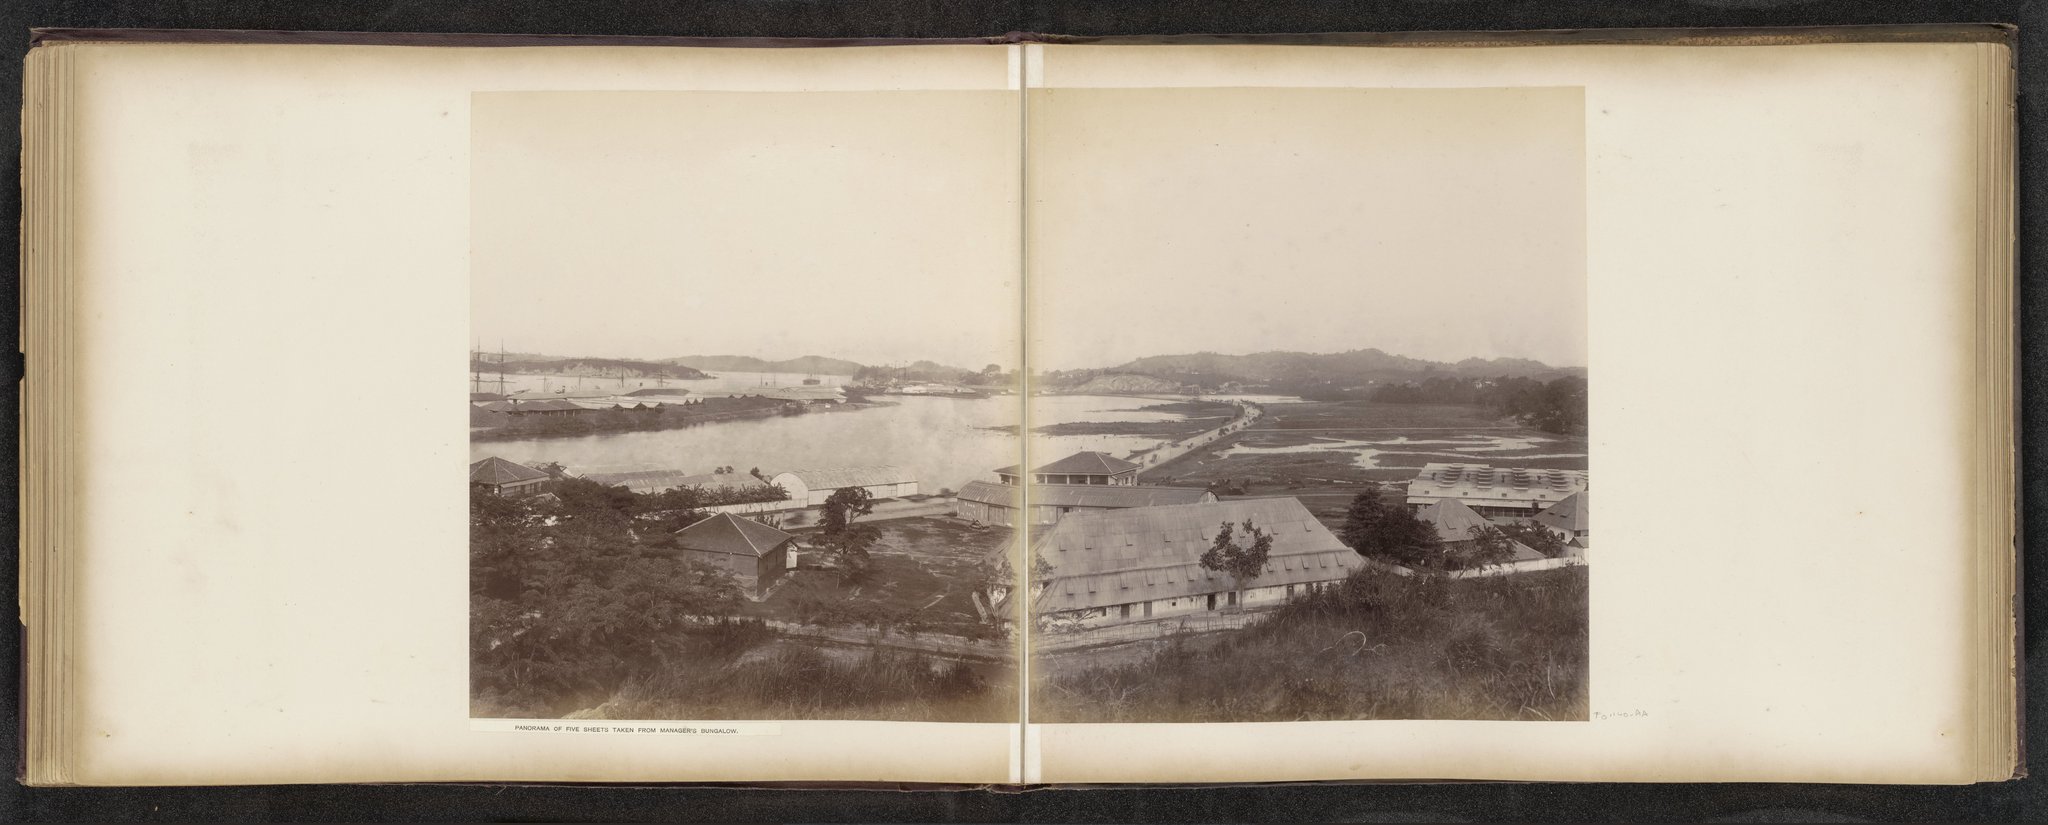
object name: panoramic photograph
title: Gezicht op gebouwen en de omgeving van de Tanjong Pagar Dock Co. Ltd. in Singapore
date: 1890-1905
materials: photographic support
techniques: albumen print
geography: singapore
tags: pier, quay, wharf, shipyard, shipdock, shipbuilding industry, singapore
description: Panorama bestaande uit vijf afdrukken. De tweede afdruk is verdeeld over de linker- en de rechterpagina van record RP-F-F01140-Z. Onderdeel van Fotoalbum van de Tanjong Pagar Dock Co. Ltd. in Singapore.